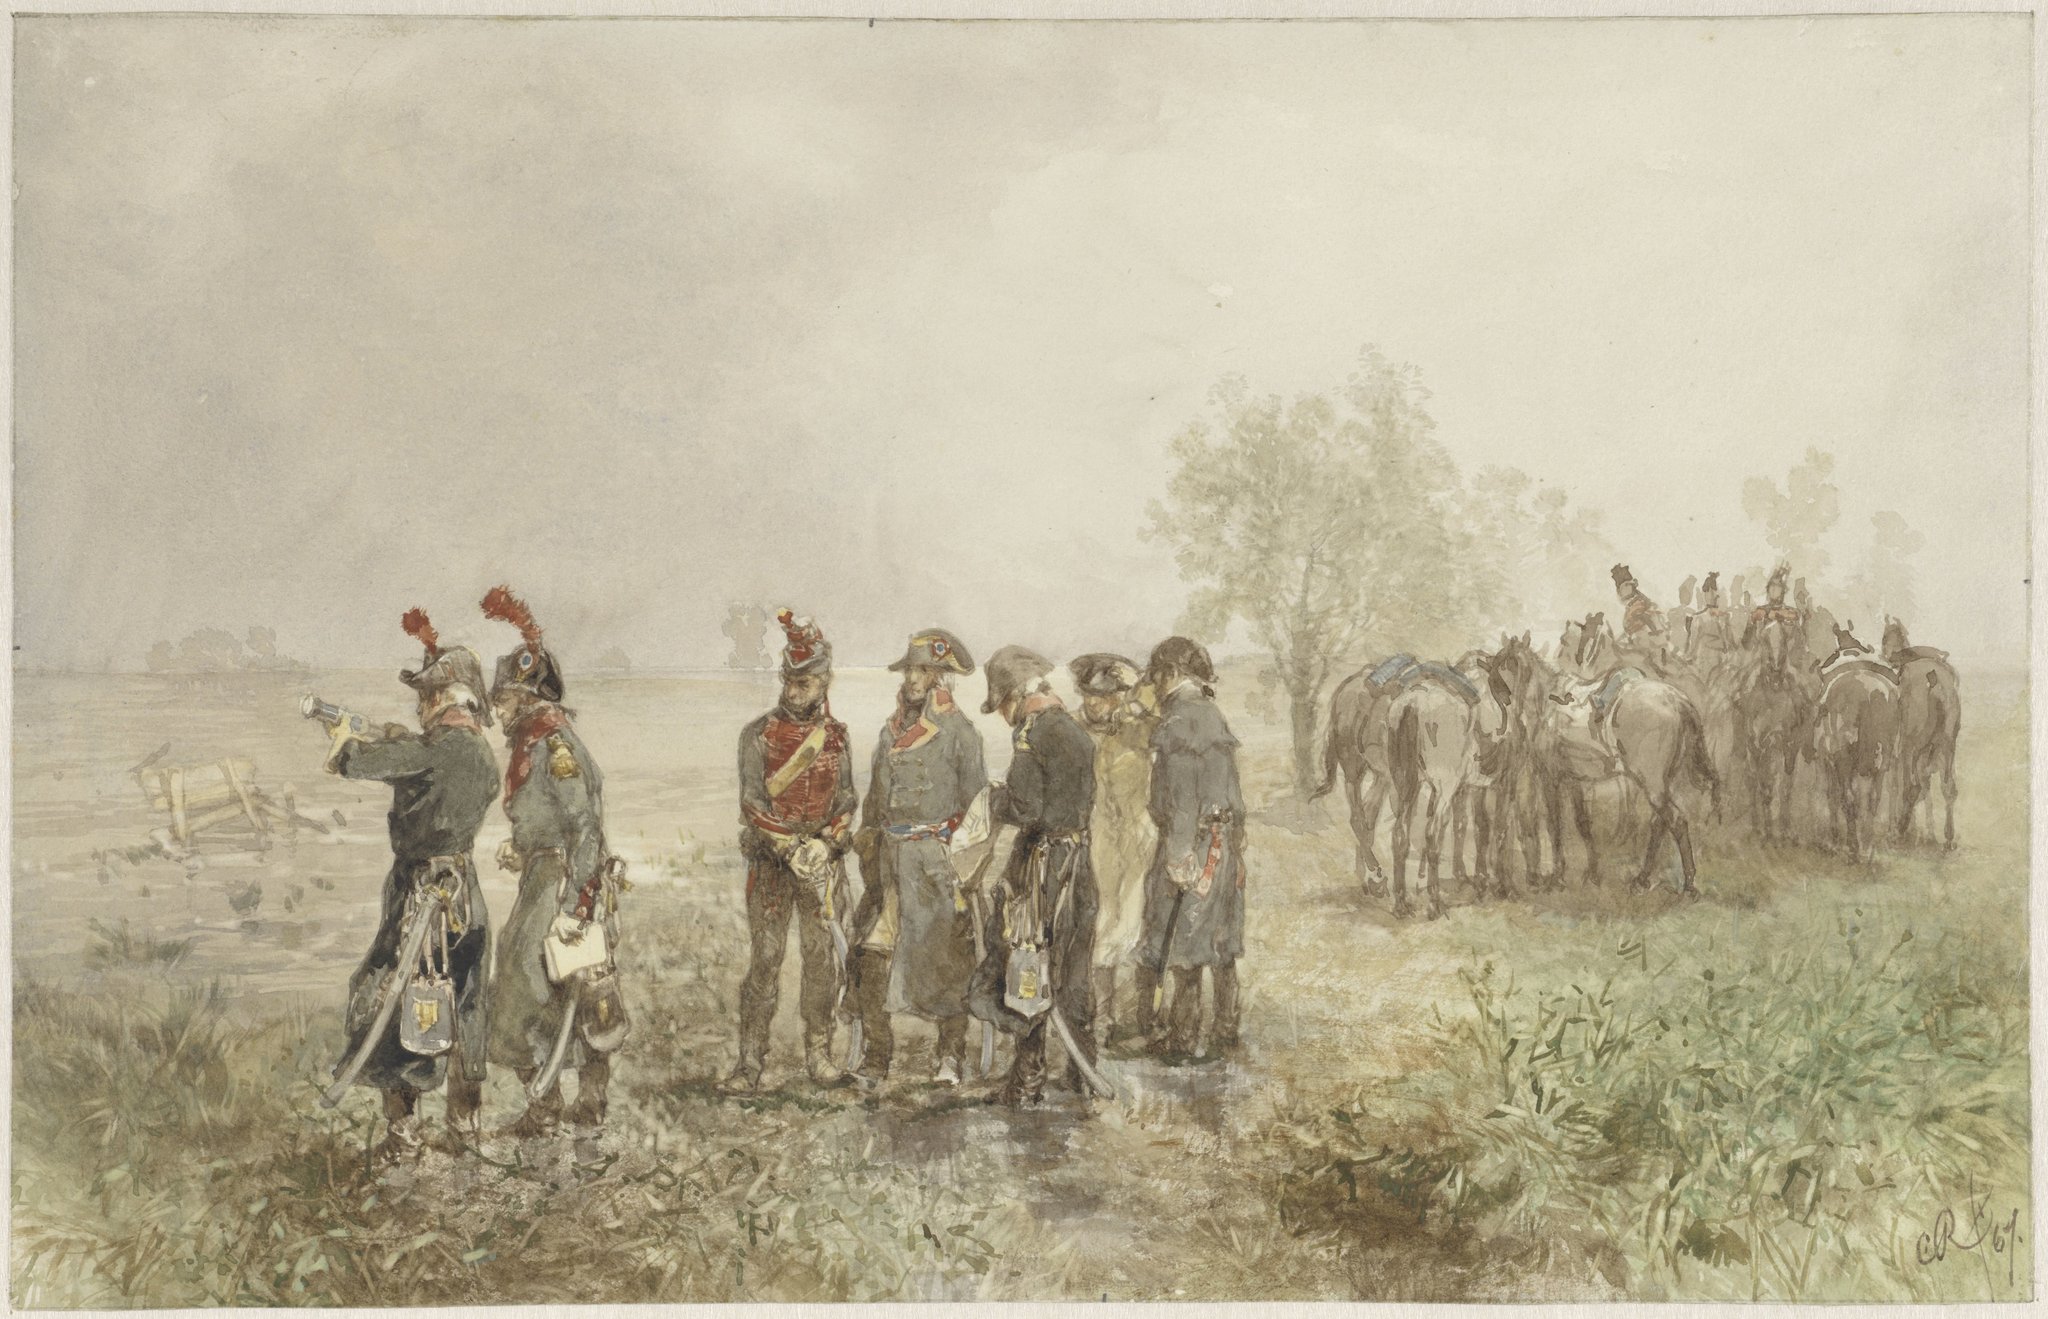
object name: drawing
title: Ontmoeting van Franse officieren in Holland, 1793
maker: charles rochussen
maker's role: draughtsman, painter, print maker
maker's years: 1814-1894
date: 1867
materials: paper, pencil, watercolor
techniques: brush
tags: river, commander-in-chief, general, marshal, officer, meeting, holland